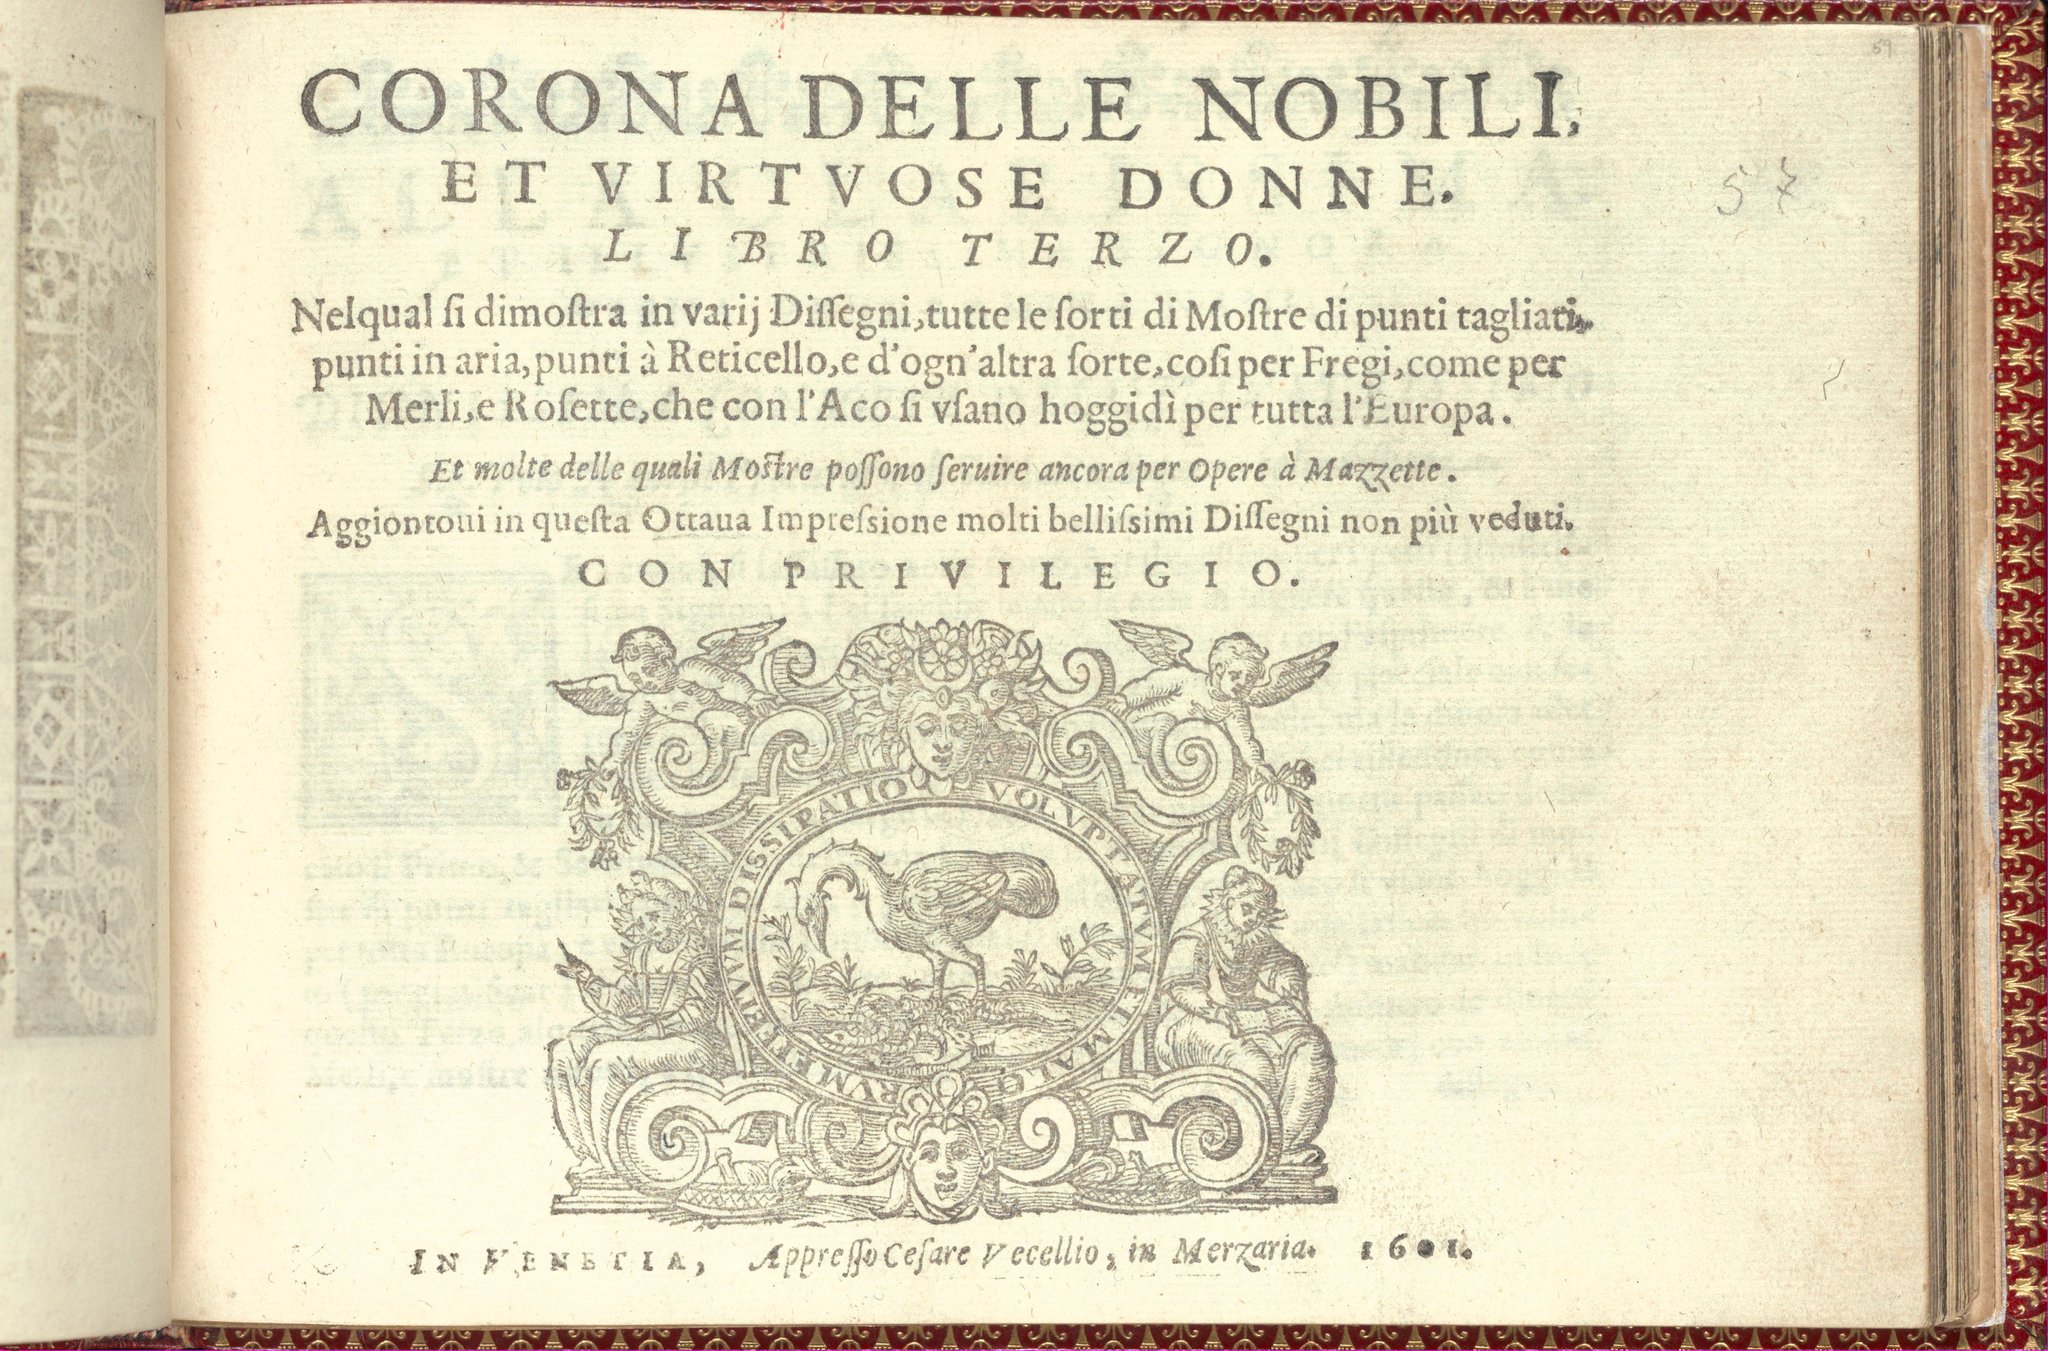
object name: book print ornament architecture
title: Corona delle Nobili et Virtuose Donne: Libro I-IV, page 57 (recto)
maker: cesare vecellio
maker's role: publisher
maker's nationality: italian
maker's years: 1521-1601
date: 1601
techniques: woodcut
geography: italy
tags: birds,women